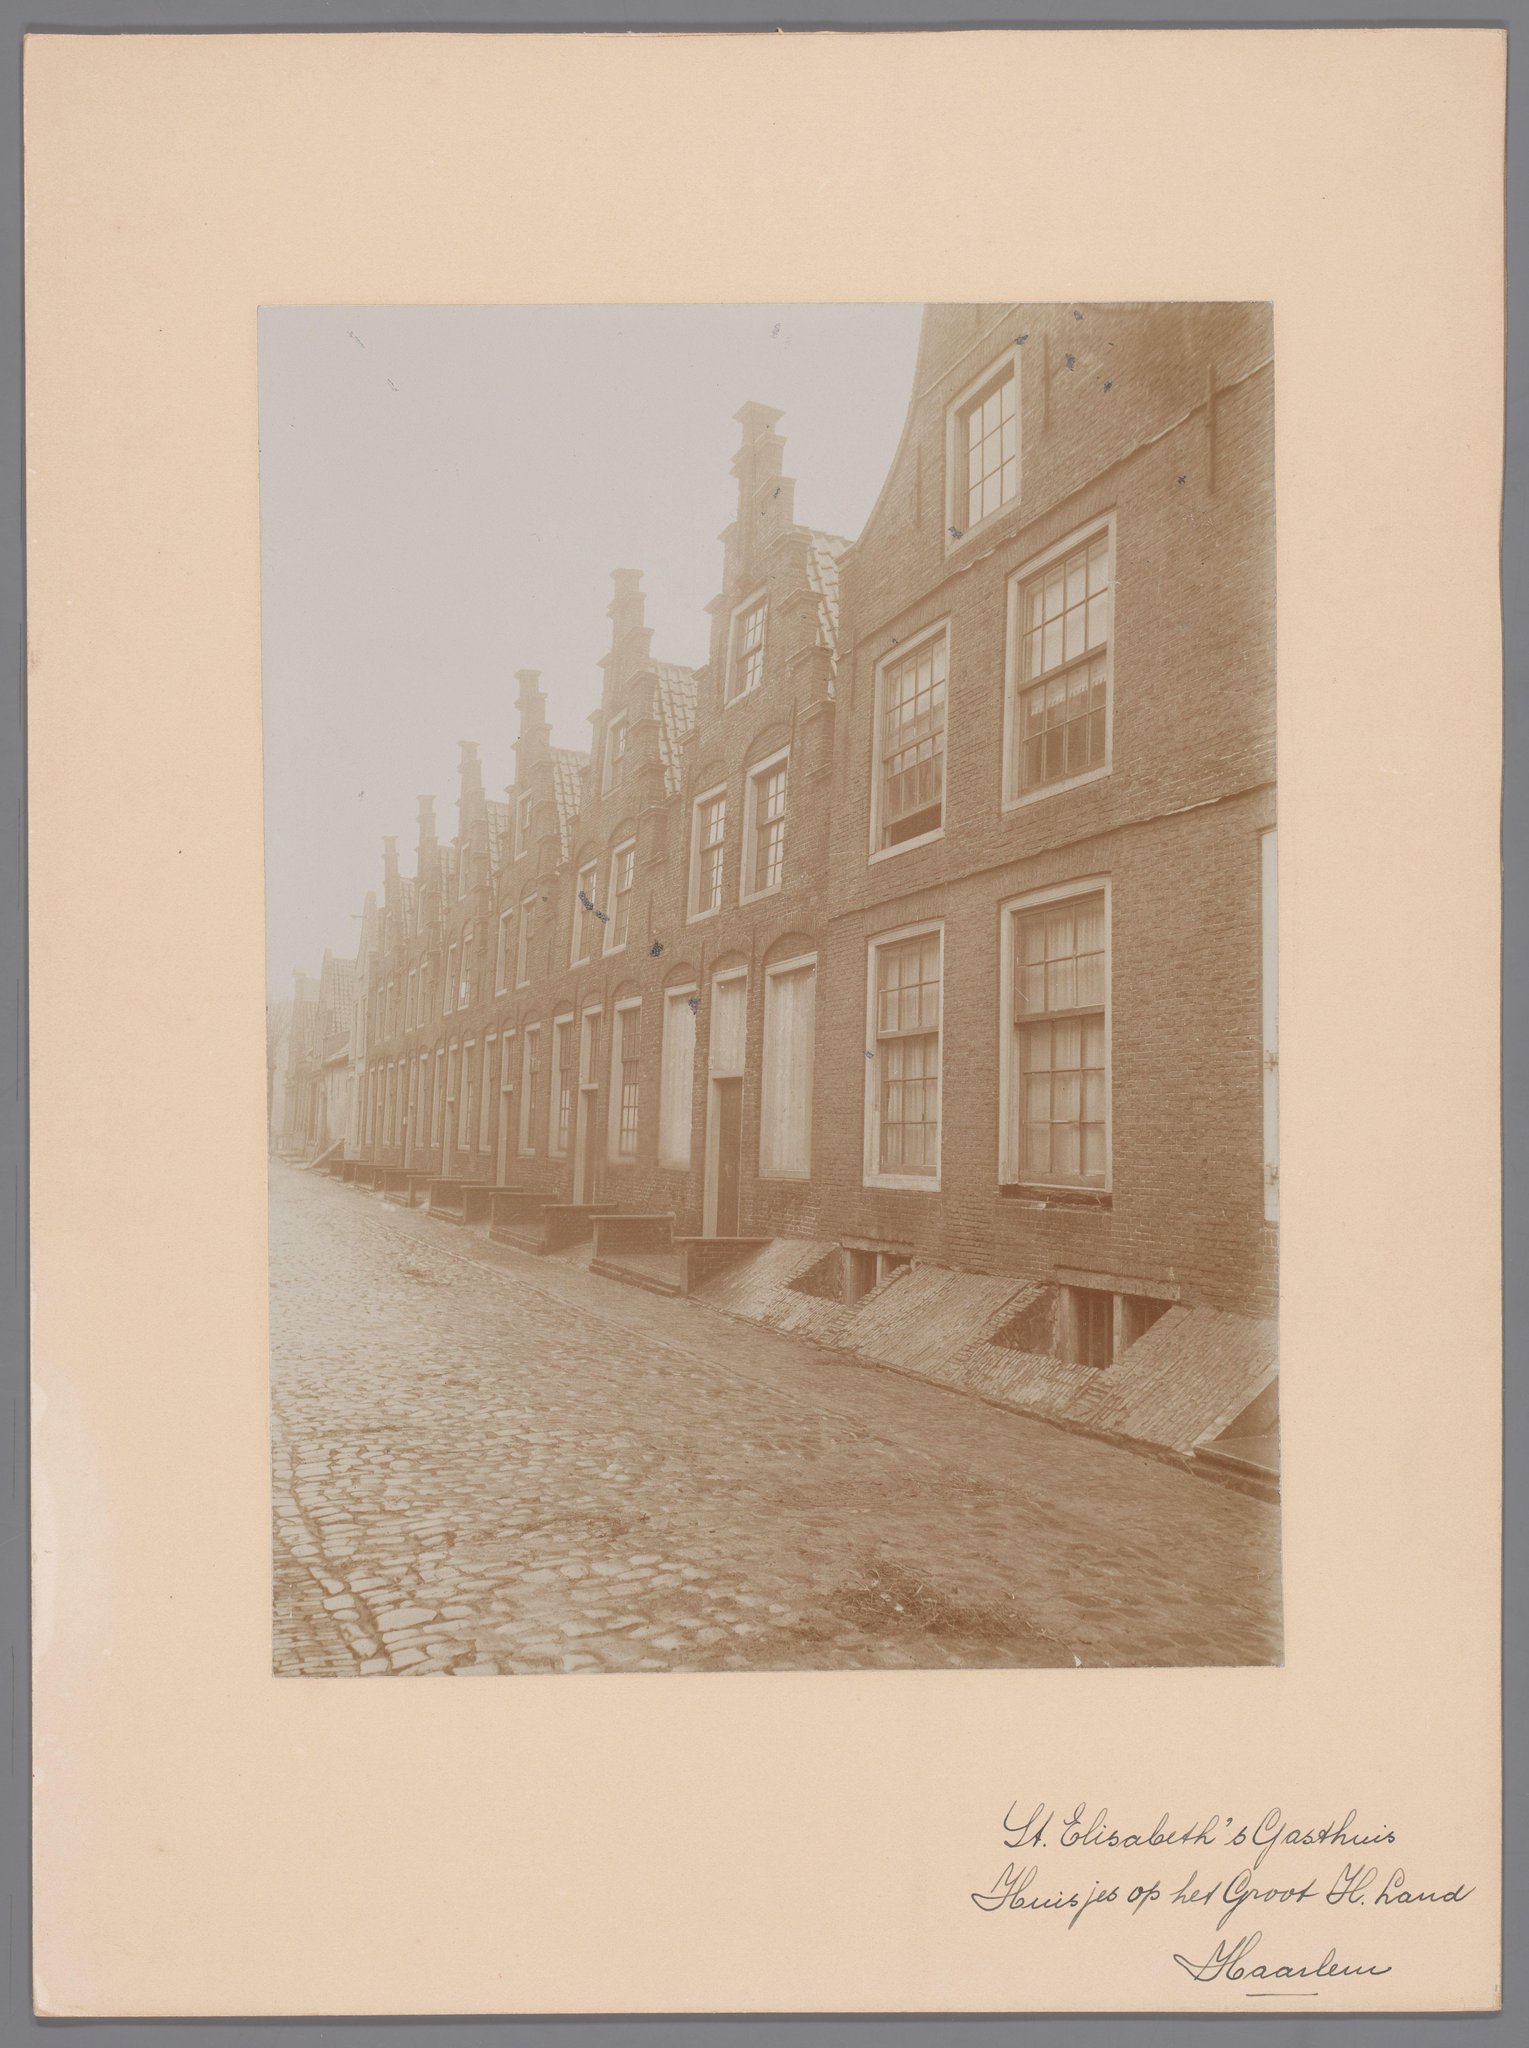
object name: photograph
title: Gezicht op de huizen van het Groot Heiligland te Haarlem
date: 1906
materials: cardboard, photographic support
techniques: collodion silver print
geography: groot heiligland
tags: urban housing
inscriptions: annotation: ‘Haarlem (N.H.)/ St. Elisabeths gasthuis/ Huisjes op het groot H. Land/ Jan 1905’, annotation: ‘St. Elisabeth's Gasthuis/ Huisjes op het Groot H. Land/ Haarlem’